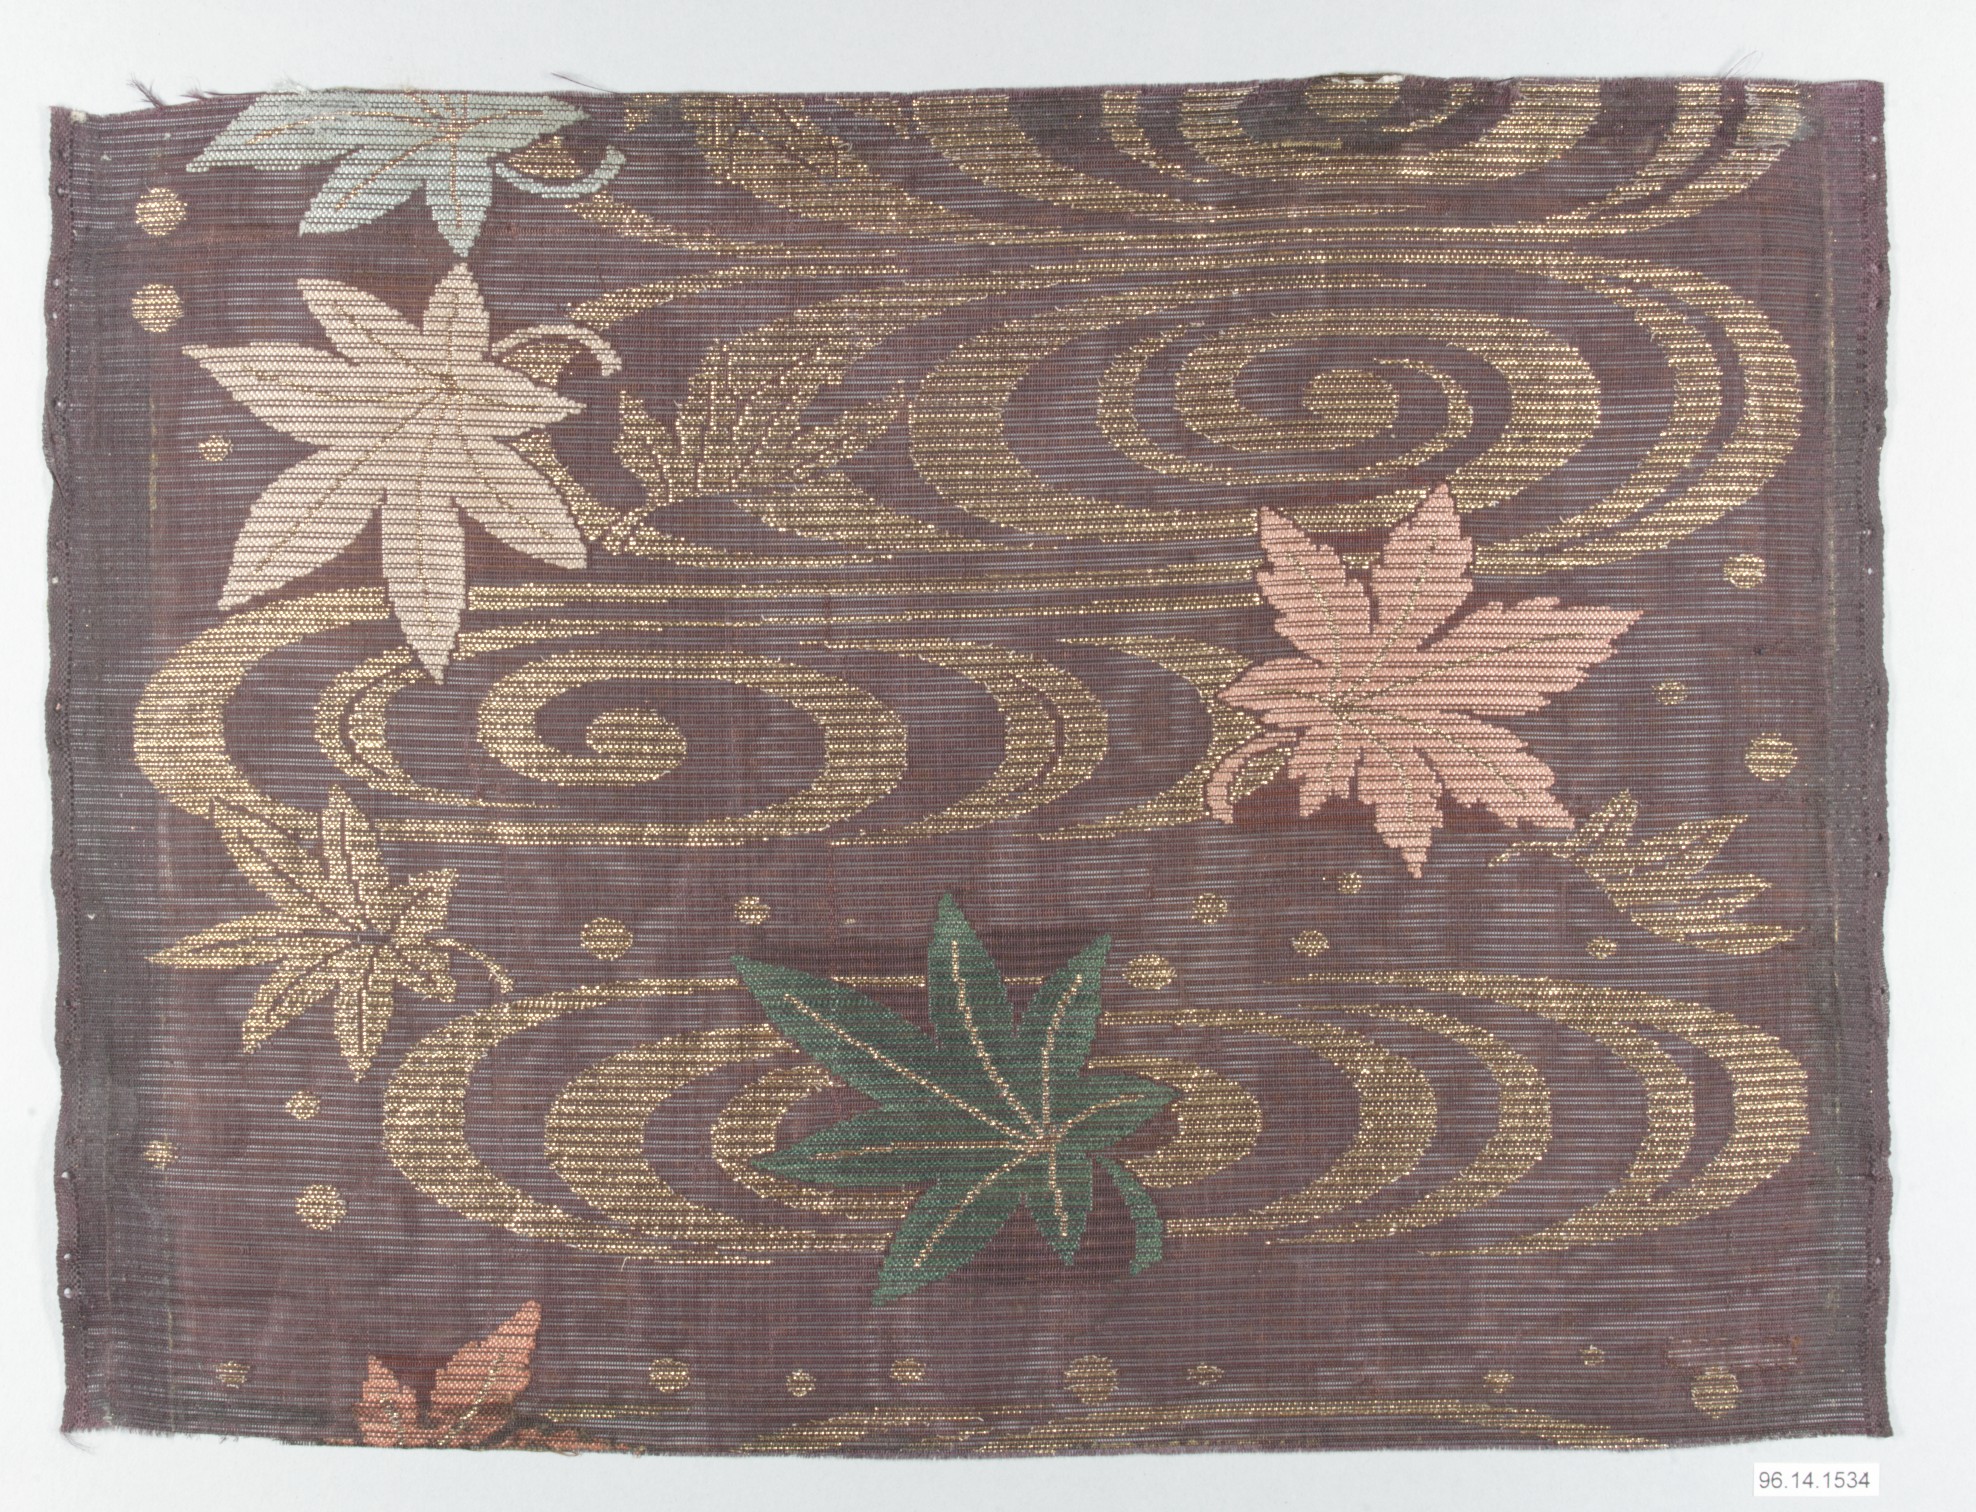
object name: piece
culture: japanese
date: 1601-1700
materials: metal thread, silk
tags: flowers